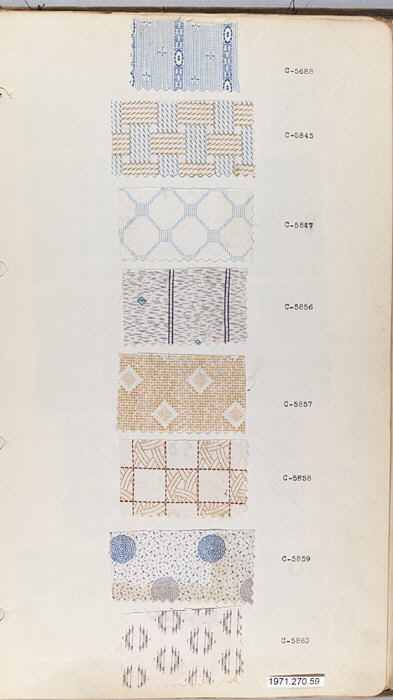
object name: sample book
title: Textile Sample Book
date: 1870-1879